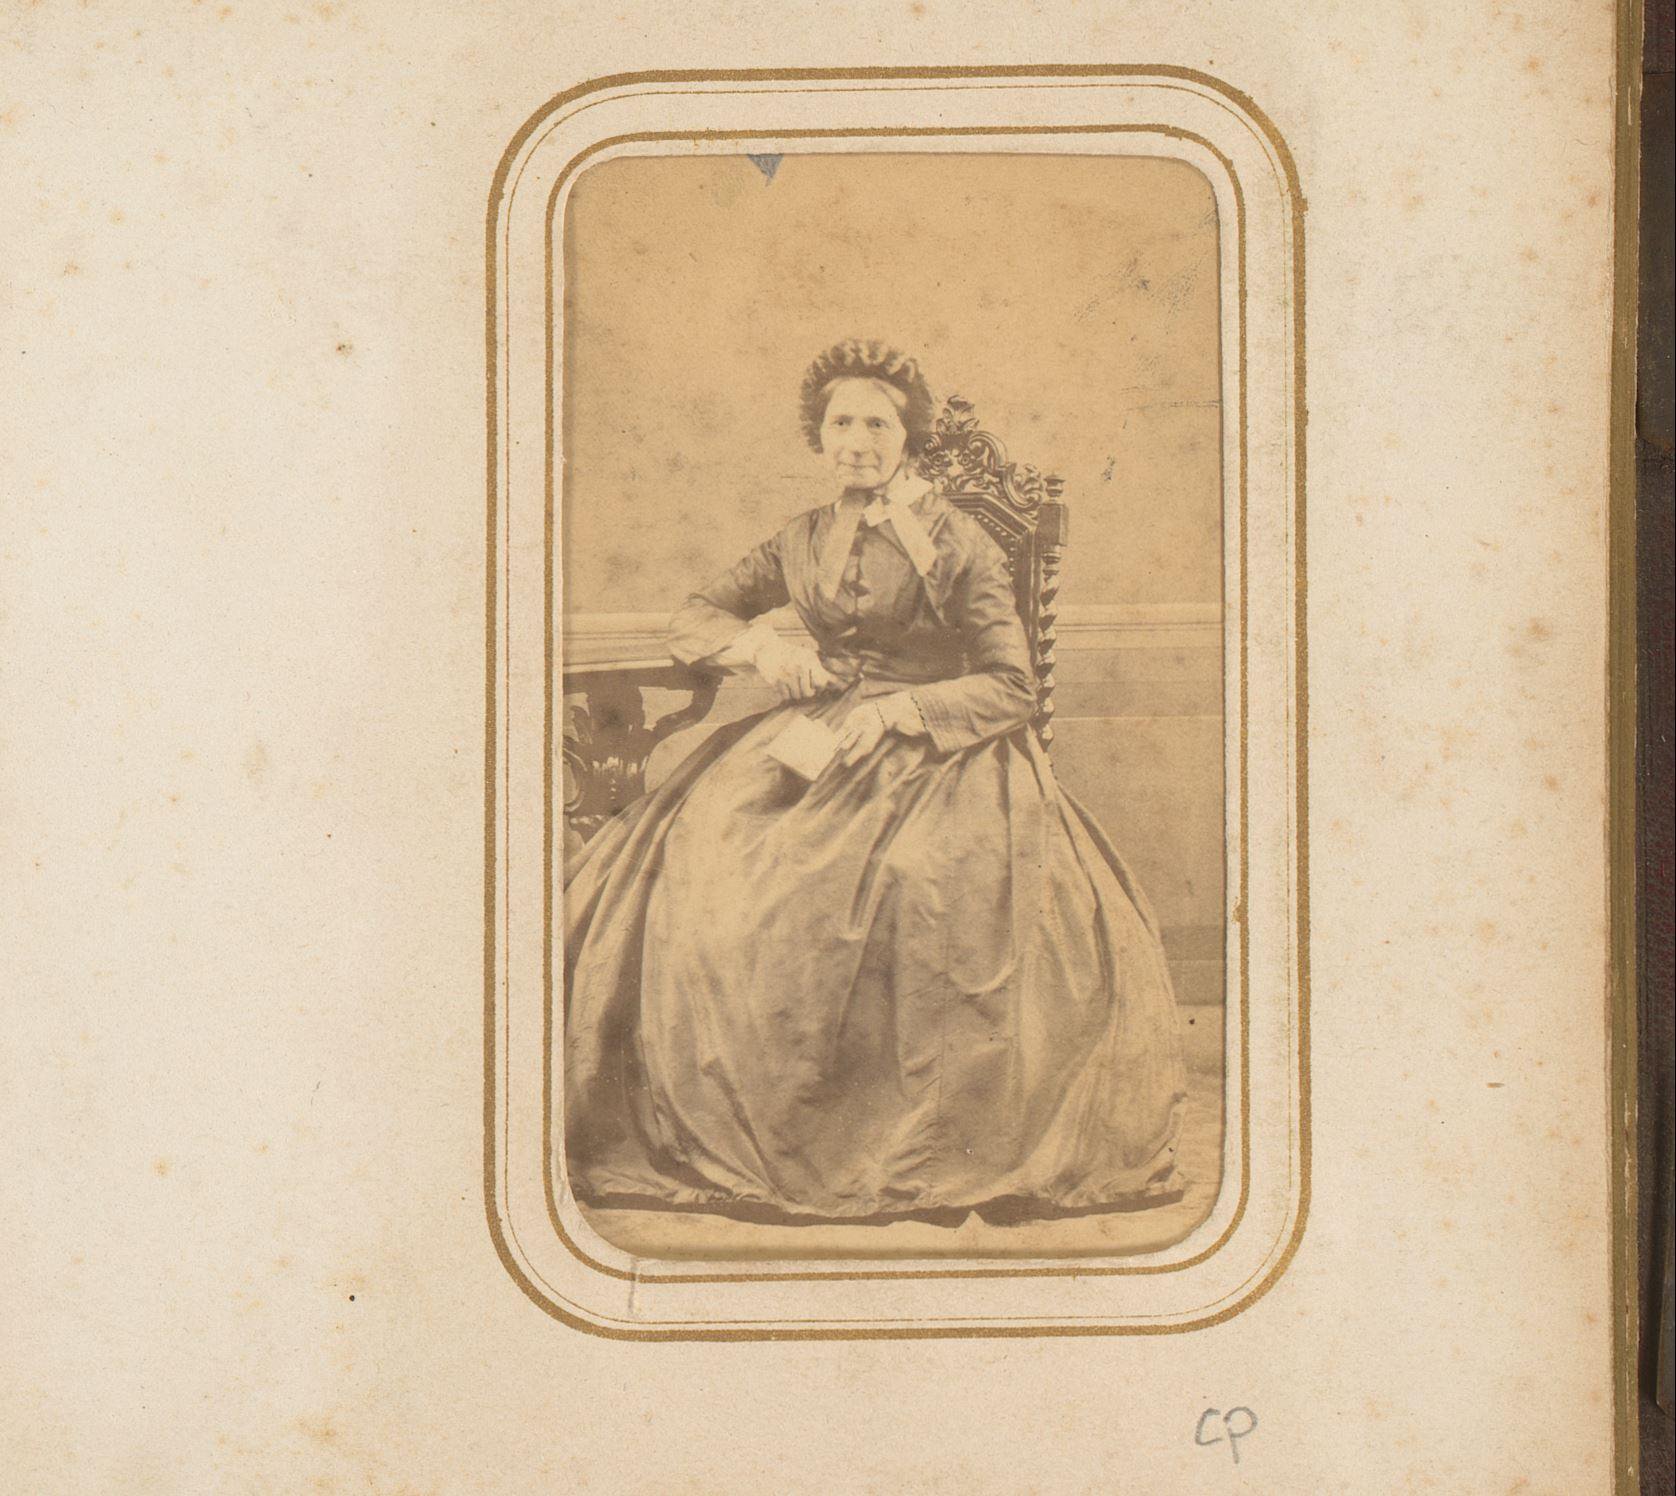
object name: album leaf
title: Portret van een zittende oude vrouw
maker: Anonymous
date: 1850-1880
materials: cardboard, photographic support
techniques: albumen print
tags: sitting figure - aa - female human figure, historical persons - bb - woman